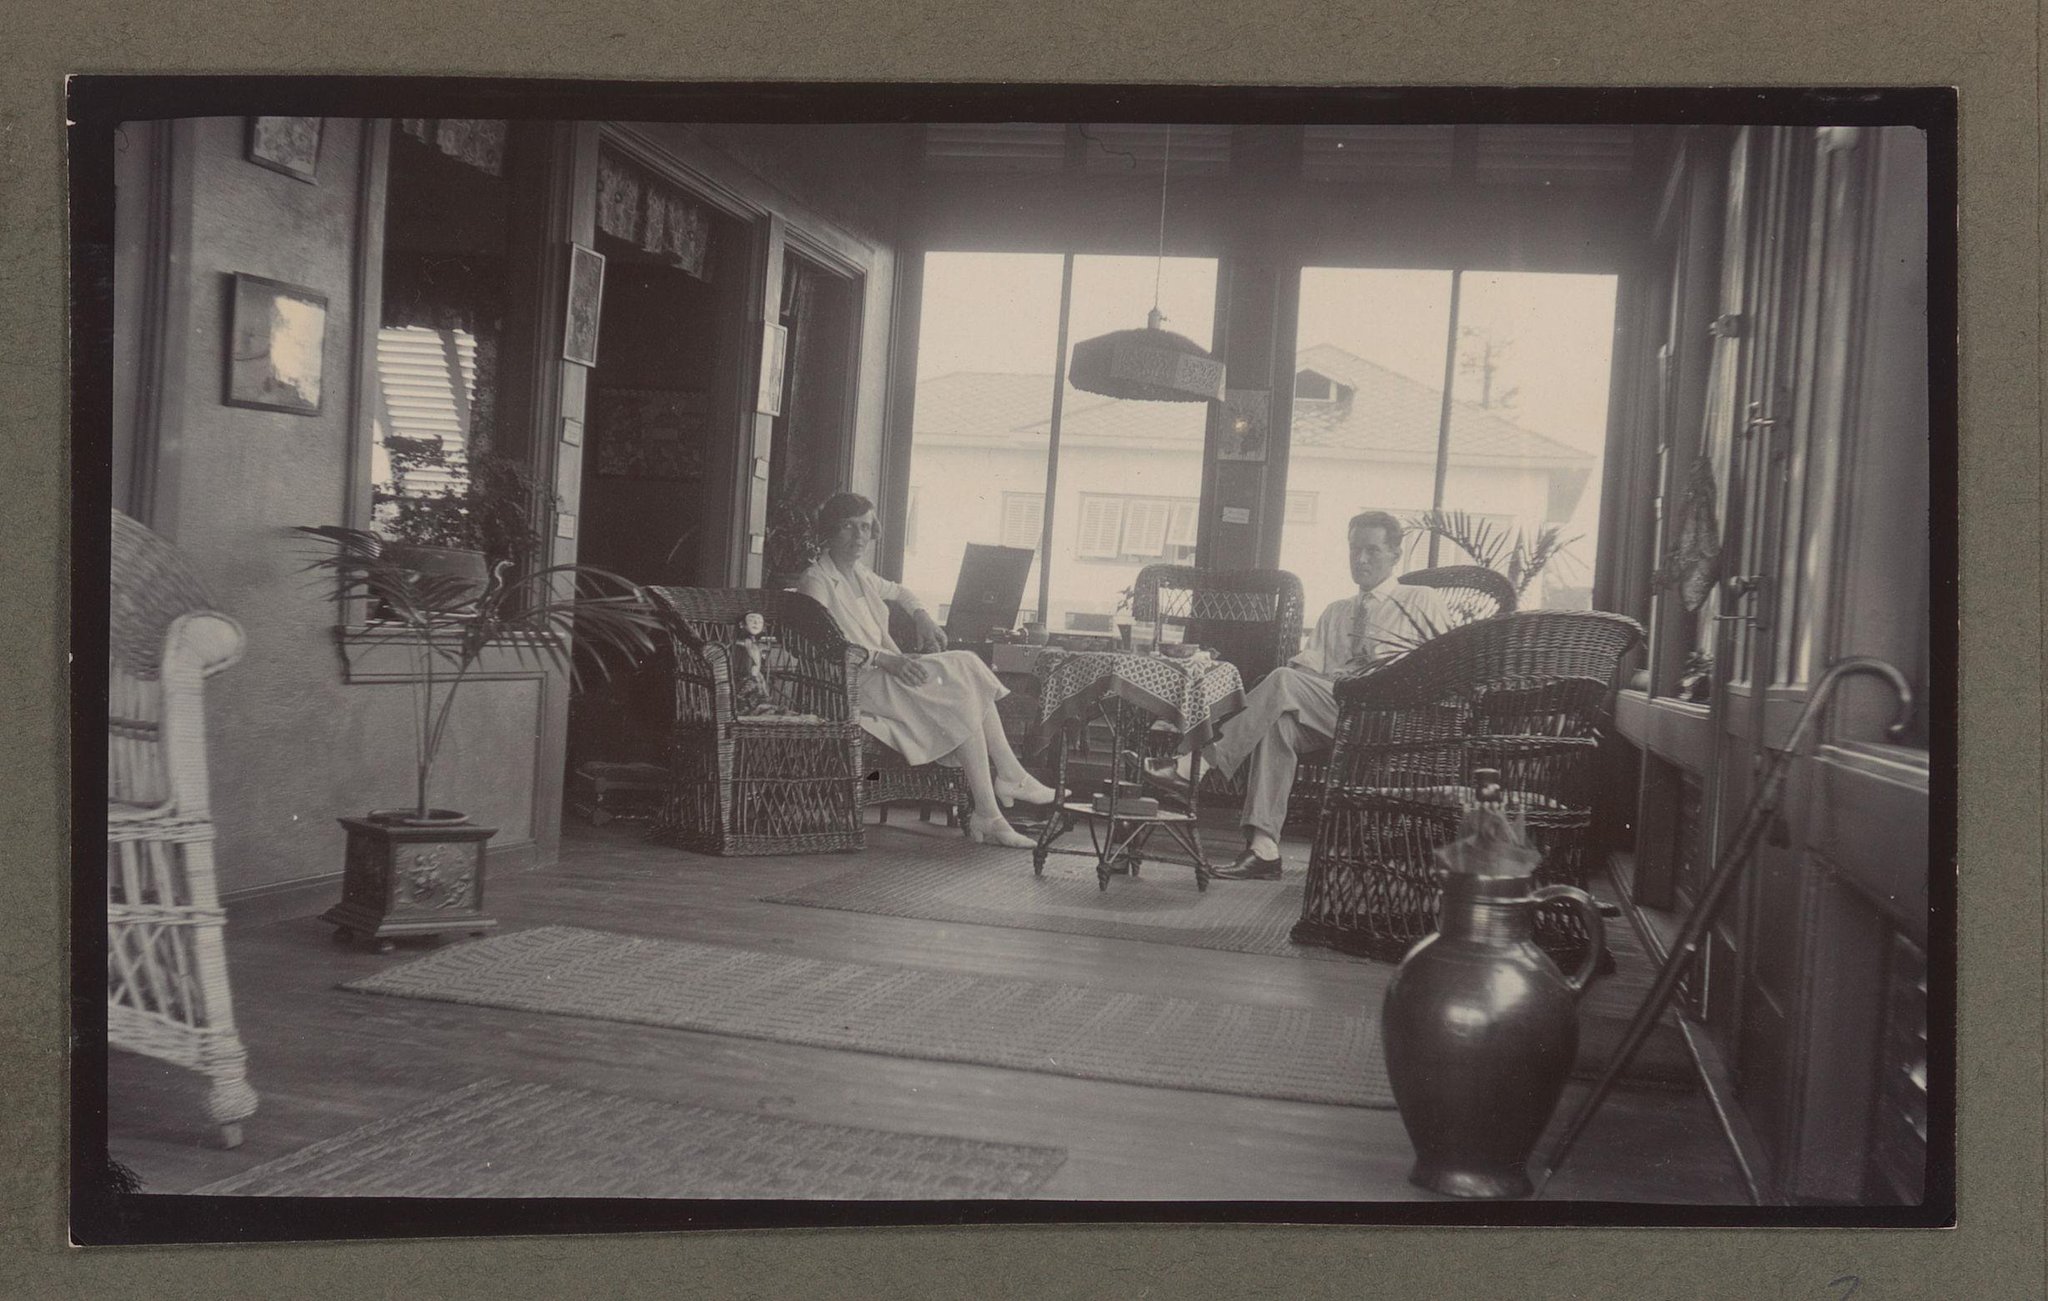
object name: photograph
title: Man en vrouw zittend in huiskamer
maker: Anonymous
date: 1903-1926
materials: photographic support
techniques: photography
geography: suriname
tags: jetten, familie, moengo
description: Man en vrouw zittend in een huiskamer (Lansvelts house). Foto op een bladzijde van een los albumblad. Onderdeel van het ensemble met foto's van de familie van ingenieur Jetten in de mijnbouwstad Moengo in Suriname.